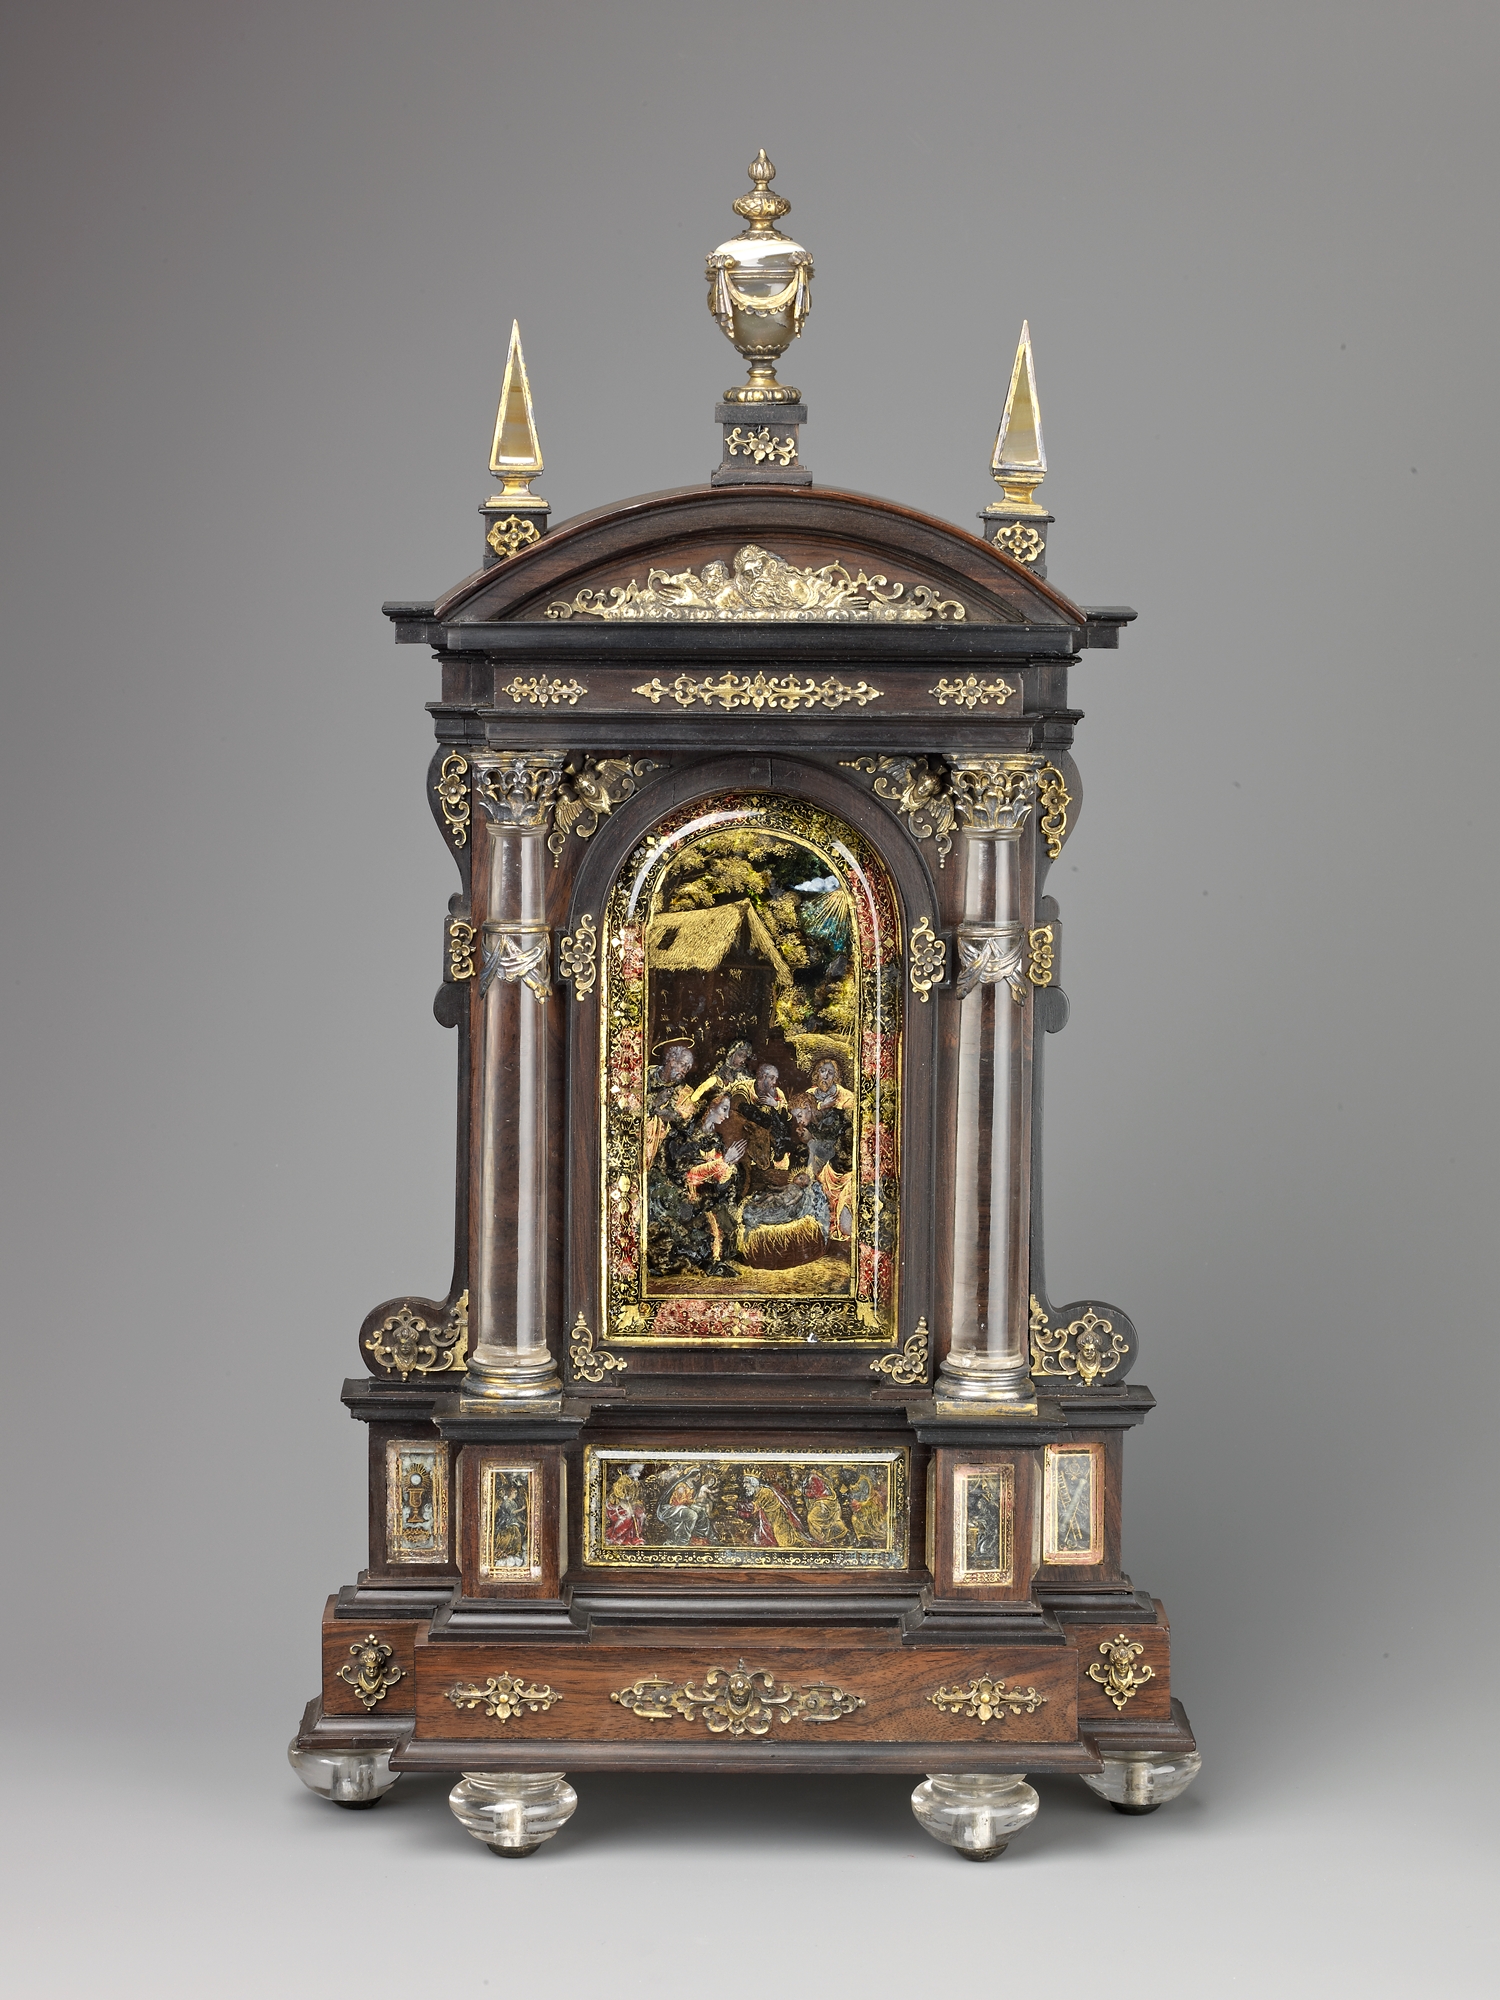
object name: tabernacle altar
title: Tabernacle House Altar with the Adoration of the Shepherds, the Adoration of the Magi, and the Annunciation.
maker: reinhold vasters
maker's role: artist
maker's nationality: german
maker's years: 1827-1909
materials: stone, wood, glass, quartz, silver gilt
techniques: gilding, painting, veneering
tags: altars,adoration of the magi,adoration of the shepherds,annunciation